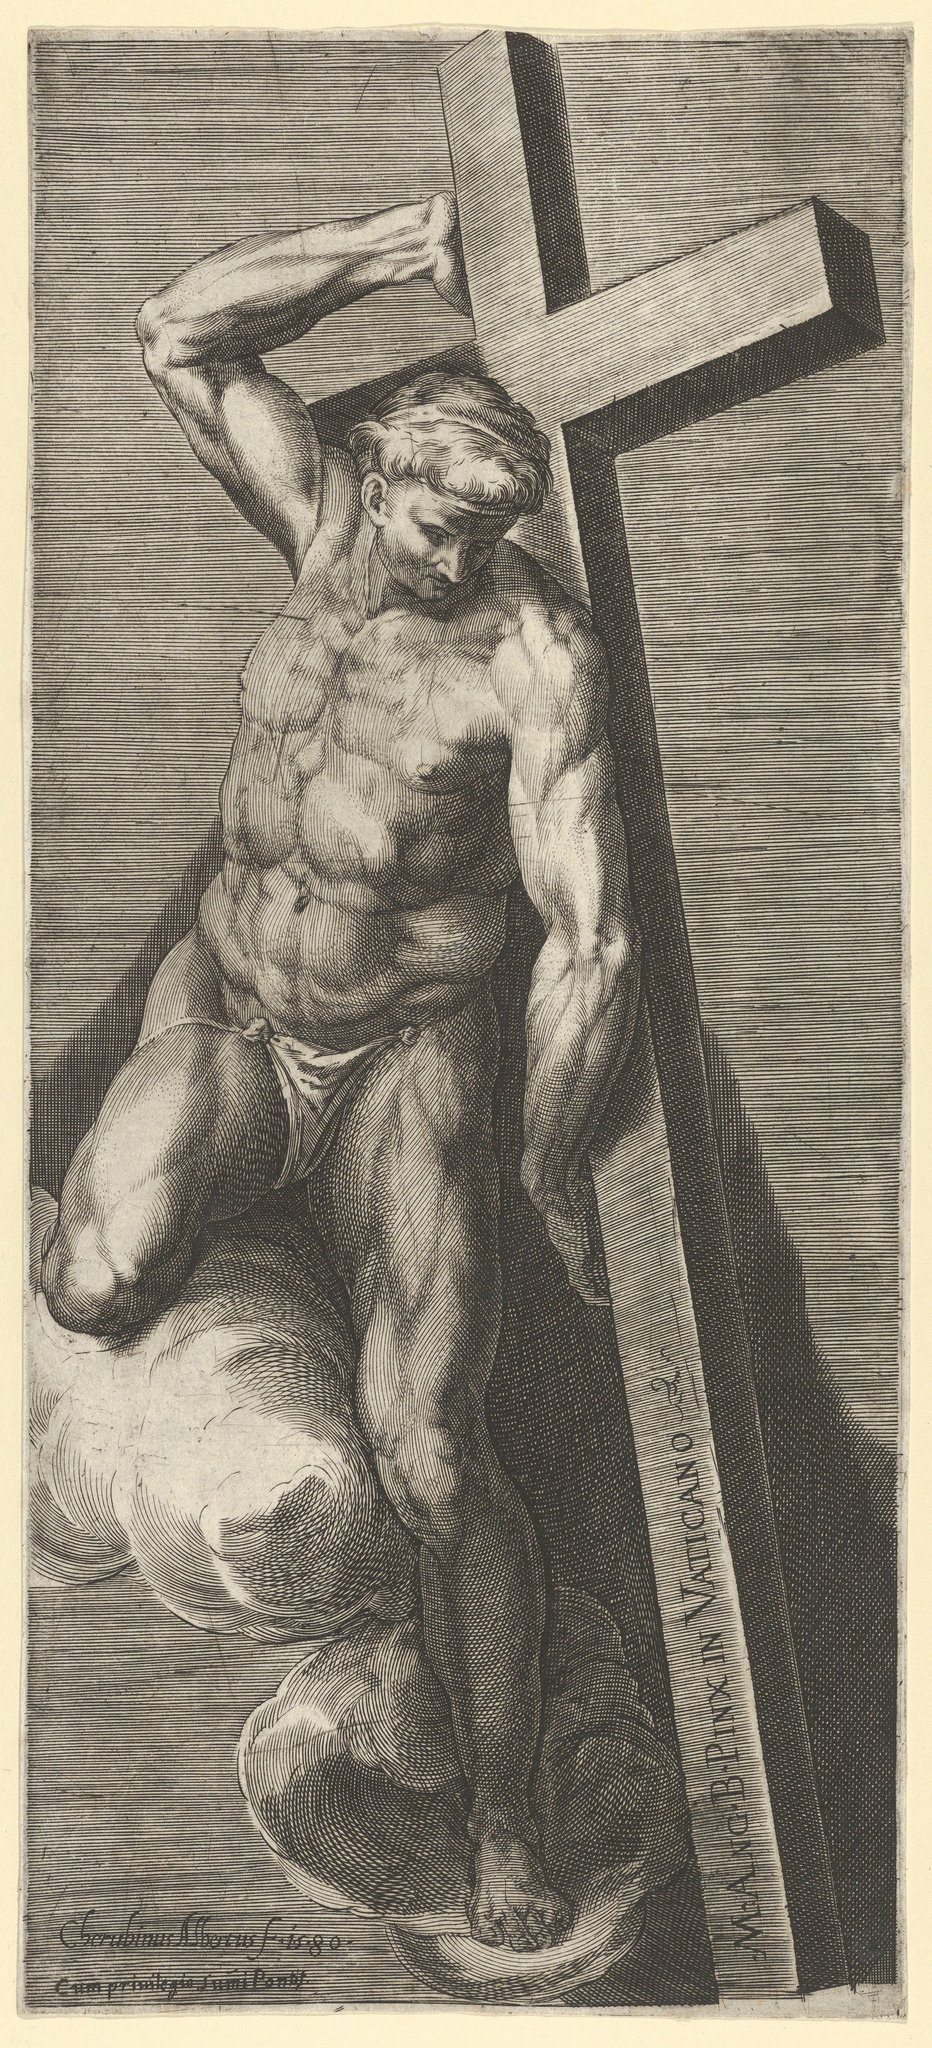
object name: print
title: The Good Thief, after Michelangelo's "The Last Judgment" fresco in the Sistine Chapel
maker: cherubino alberti (zaccaria mattia)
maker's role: artist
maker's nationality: italian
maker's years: 1553-1615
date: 1580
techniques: engraving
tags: men,cross,last judgement